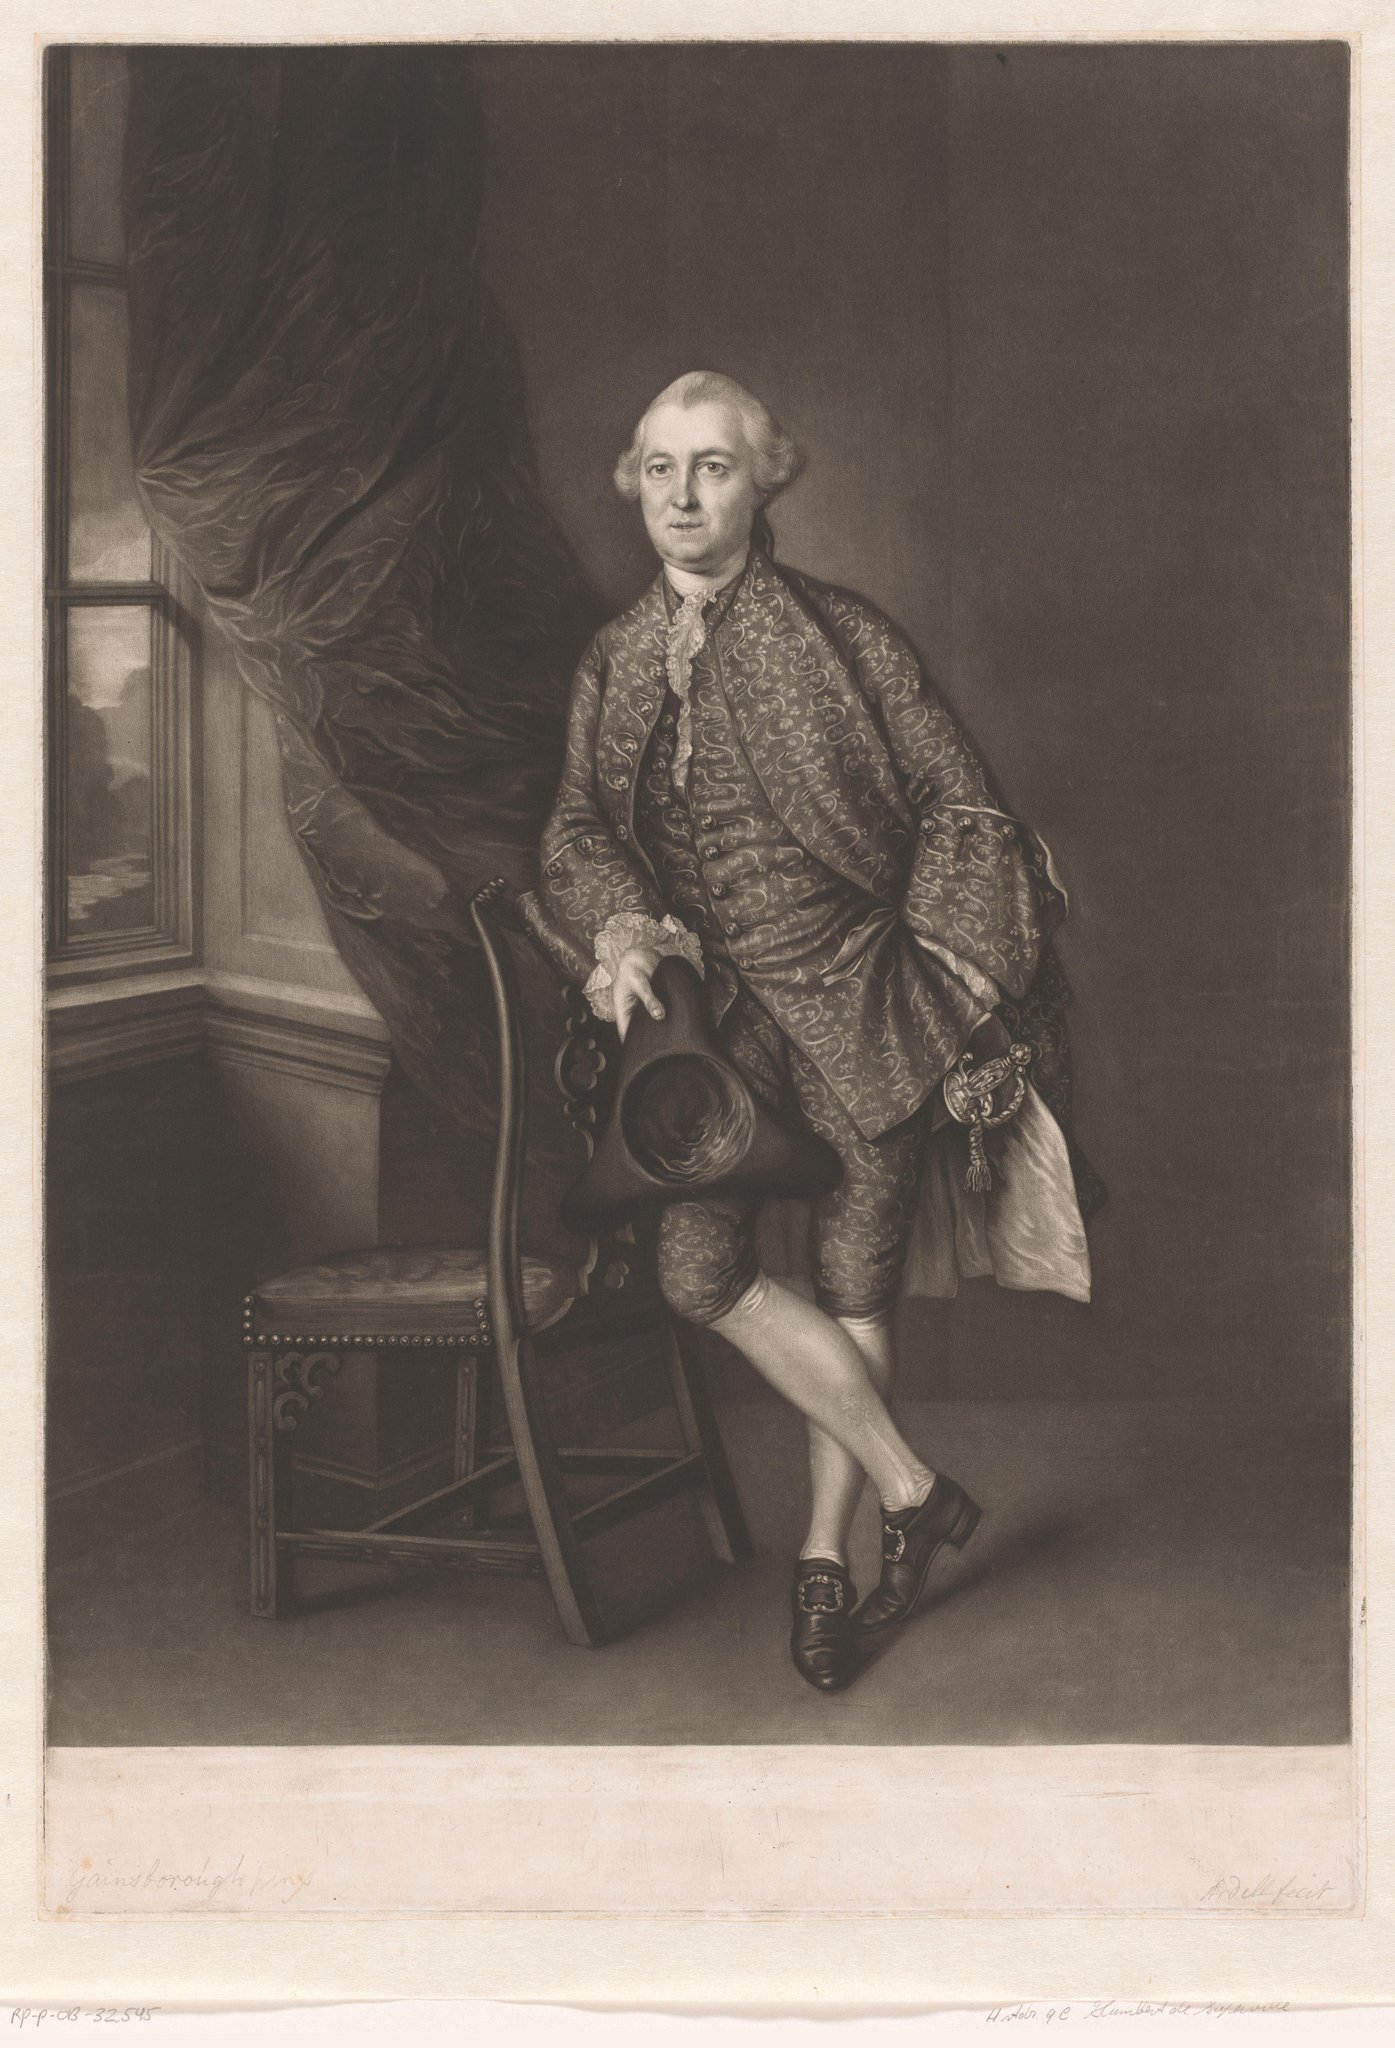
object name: print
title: Portret van Edward Turner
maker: james mcardell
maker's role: print maker, publisher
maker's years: 1728-1765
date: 1763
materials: paper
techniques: mezzotint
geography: london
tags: historical persons, politician, e.g. party leader, human figure at (open) window, seen from inside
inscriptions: collector's mark: Lugt 240